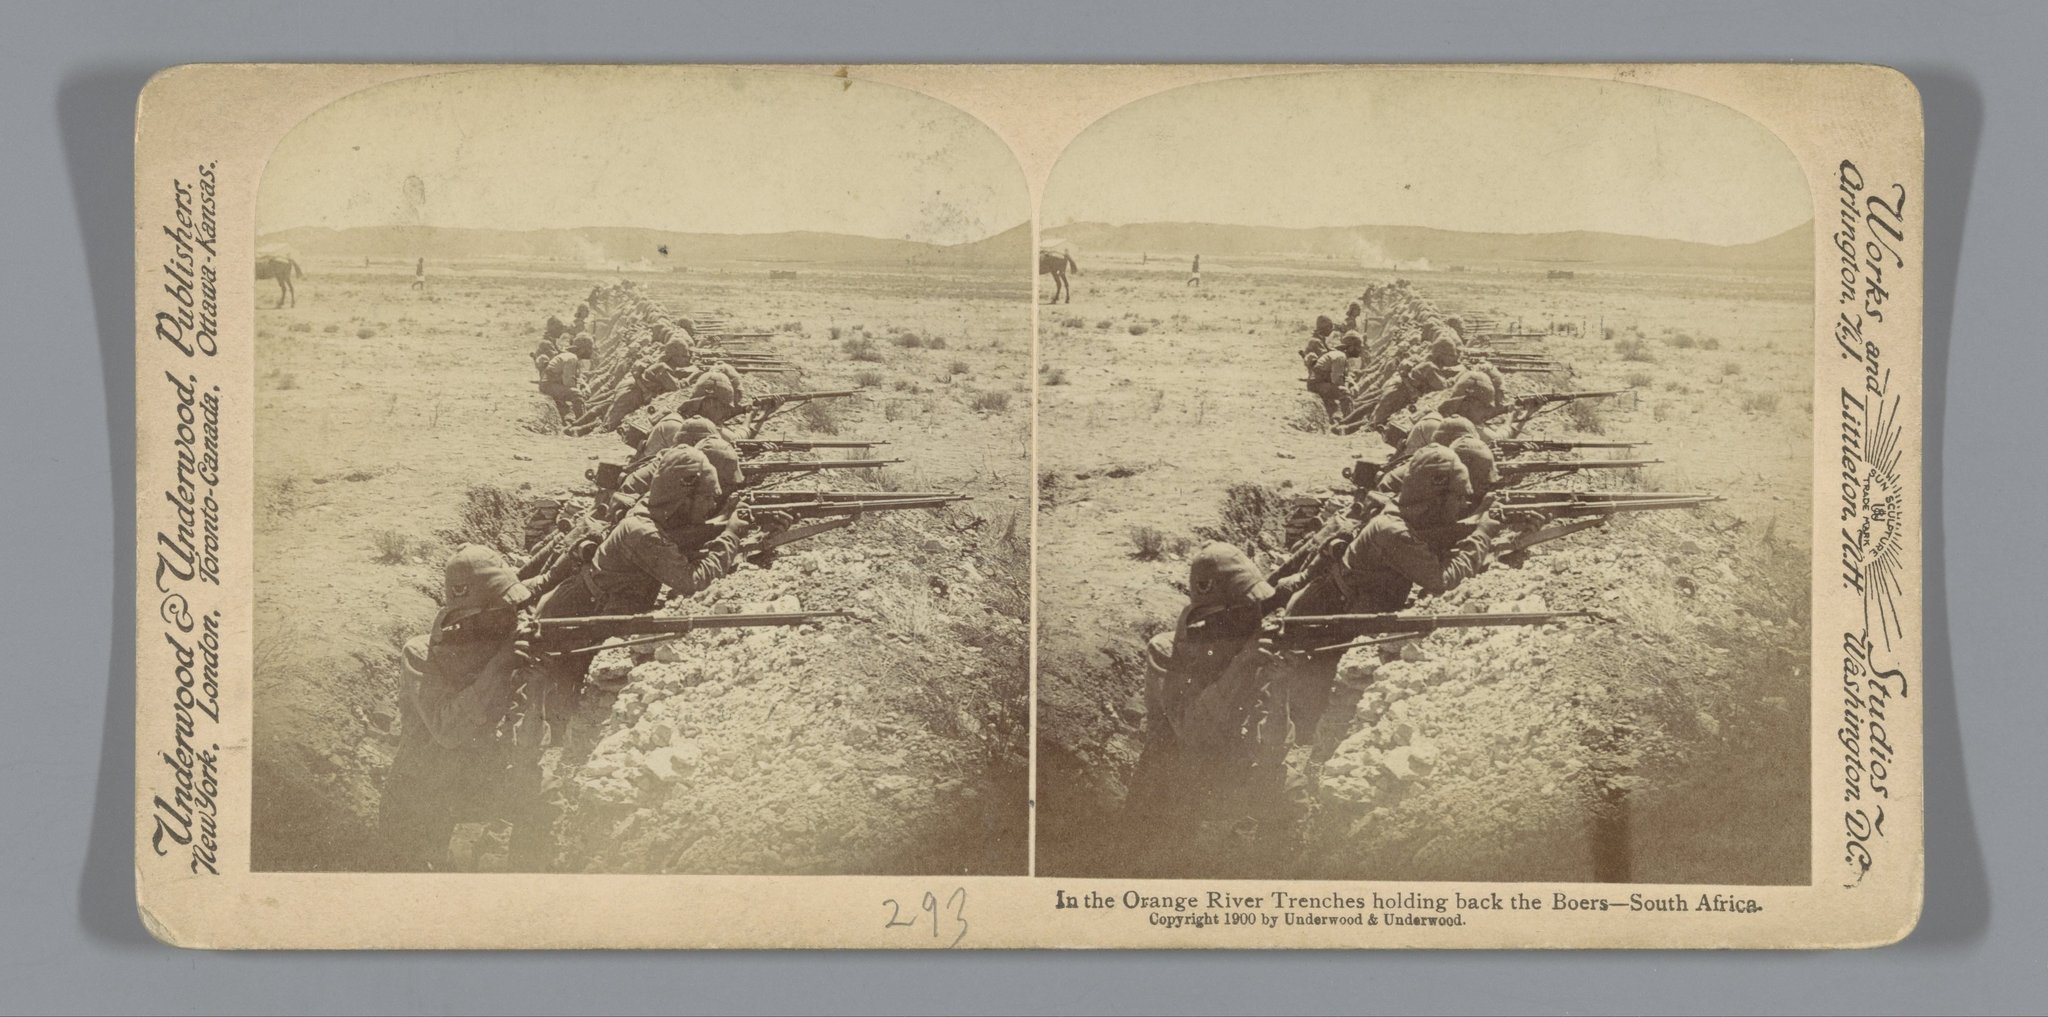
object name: stereograph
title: Behind the Orange River Intrenchments holding back the bravely advancing Boers - S. Africa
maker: Anonymous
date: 1900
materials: cardboard, paper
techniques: albumen print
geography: orange river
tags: the soldier; the soldier's life, trenches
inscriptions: inscription: ‘Works and Studios ~/ Arlington, N.J. Littleton, N.H. Washington, D.C.’, number: ‘293’, copyright notice: ‘Copyright 1900 by Underwood & Underwood.’, inscription